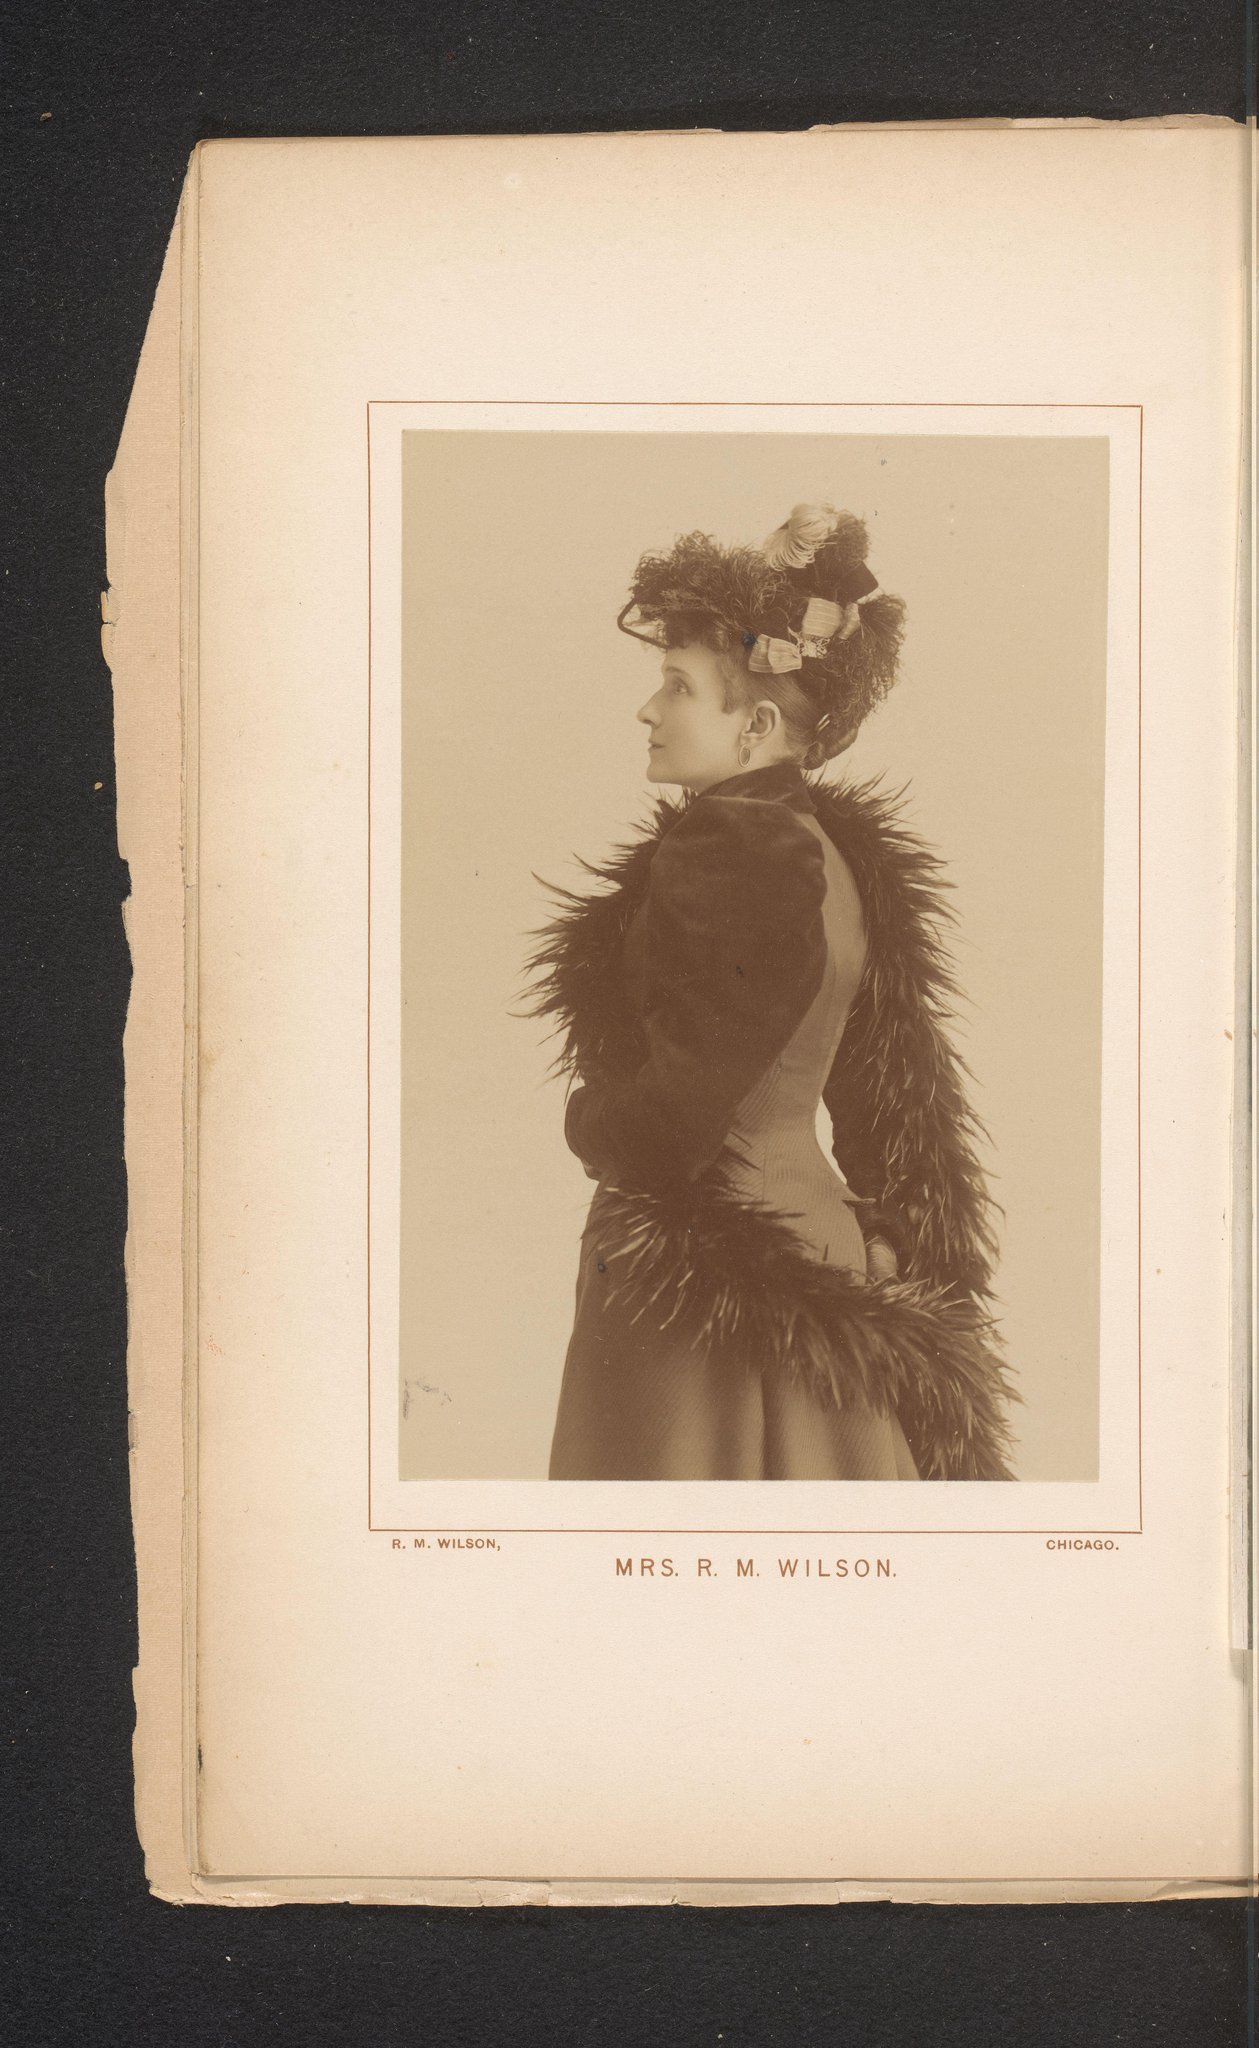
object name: page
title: A Vignette Study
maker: p.h. rose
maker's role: fotograaf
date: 1887-1892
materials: photographic support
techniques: albumen print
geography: providence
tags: historical persons not known by name - bb - woman, girl (child between toddler and youth), (playing with) dolls